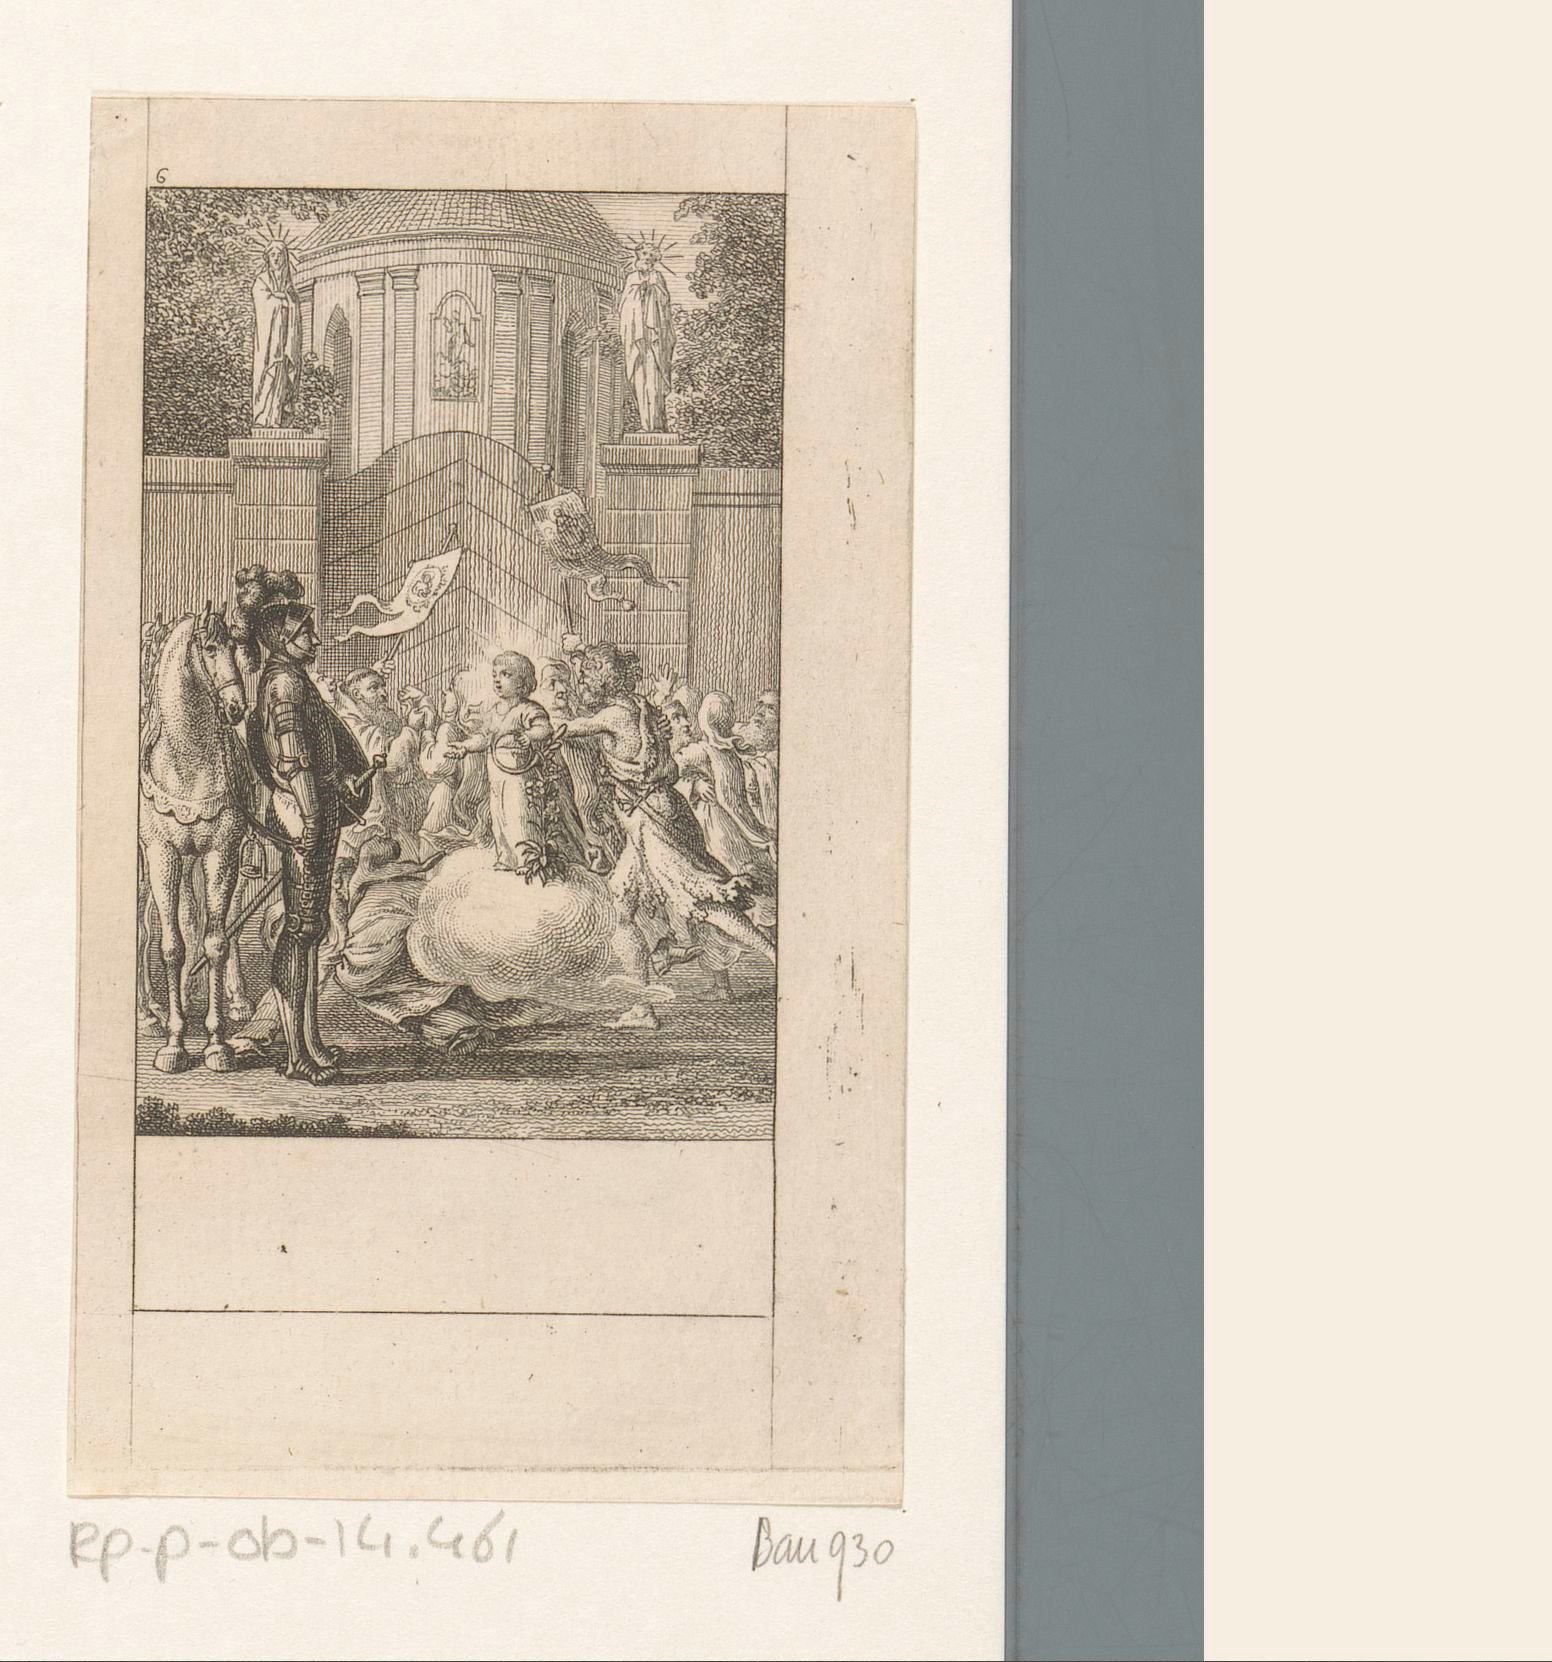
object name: print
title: Huon de Bordeaux wordt toegesproken door de feeënkoning Oberon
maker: daniel nikolaus chodowiecki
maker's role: draughtsman, print maker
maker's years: 1726-1801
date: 1782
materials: paper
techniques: etching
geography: berlin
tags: armour, flight, running away; pursuing, sitting or standing on clouds, child (at home)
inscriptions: collector's mark: Lugt 2228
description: Vervaardigd voor Tressans 'Huon de Bordeaux'. Latere staat gebruikt voor: Almanac de Gotha contenant diverses connaissances curieuses et utiles pour l'année MDCCLXXXIII. Gotha: C. W. Ettinger, 1782.